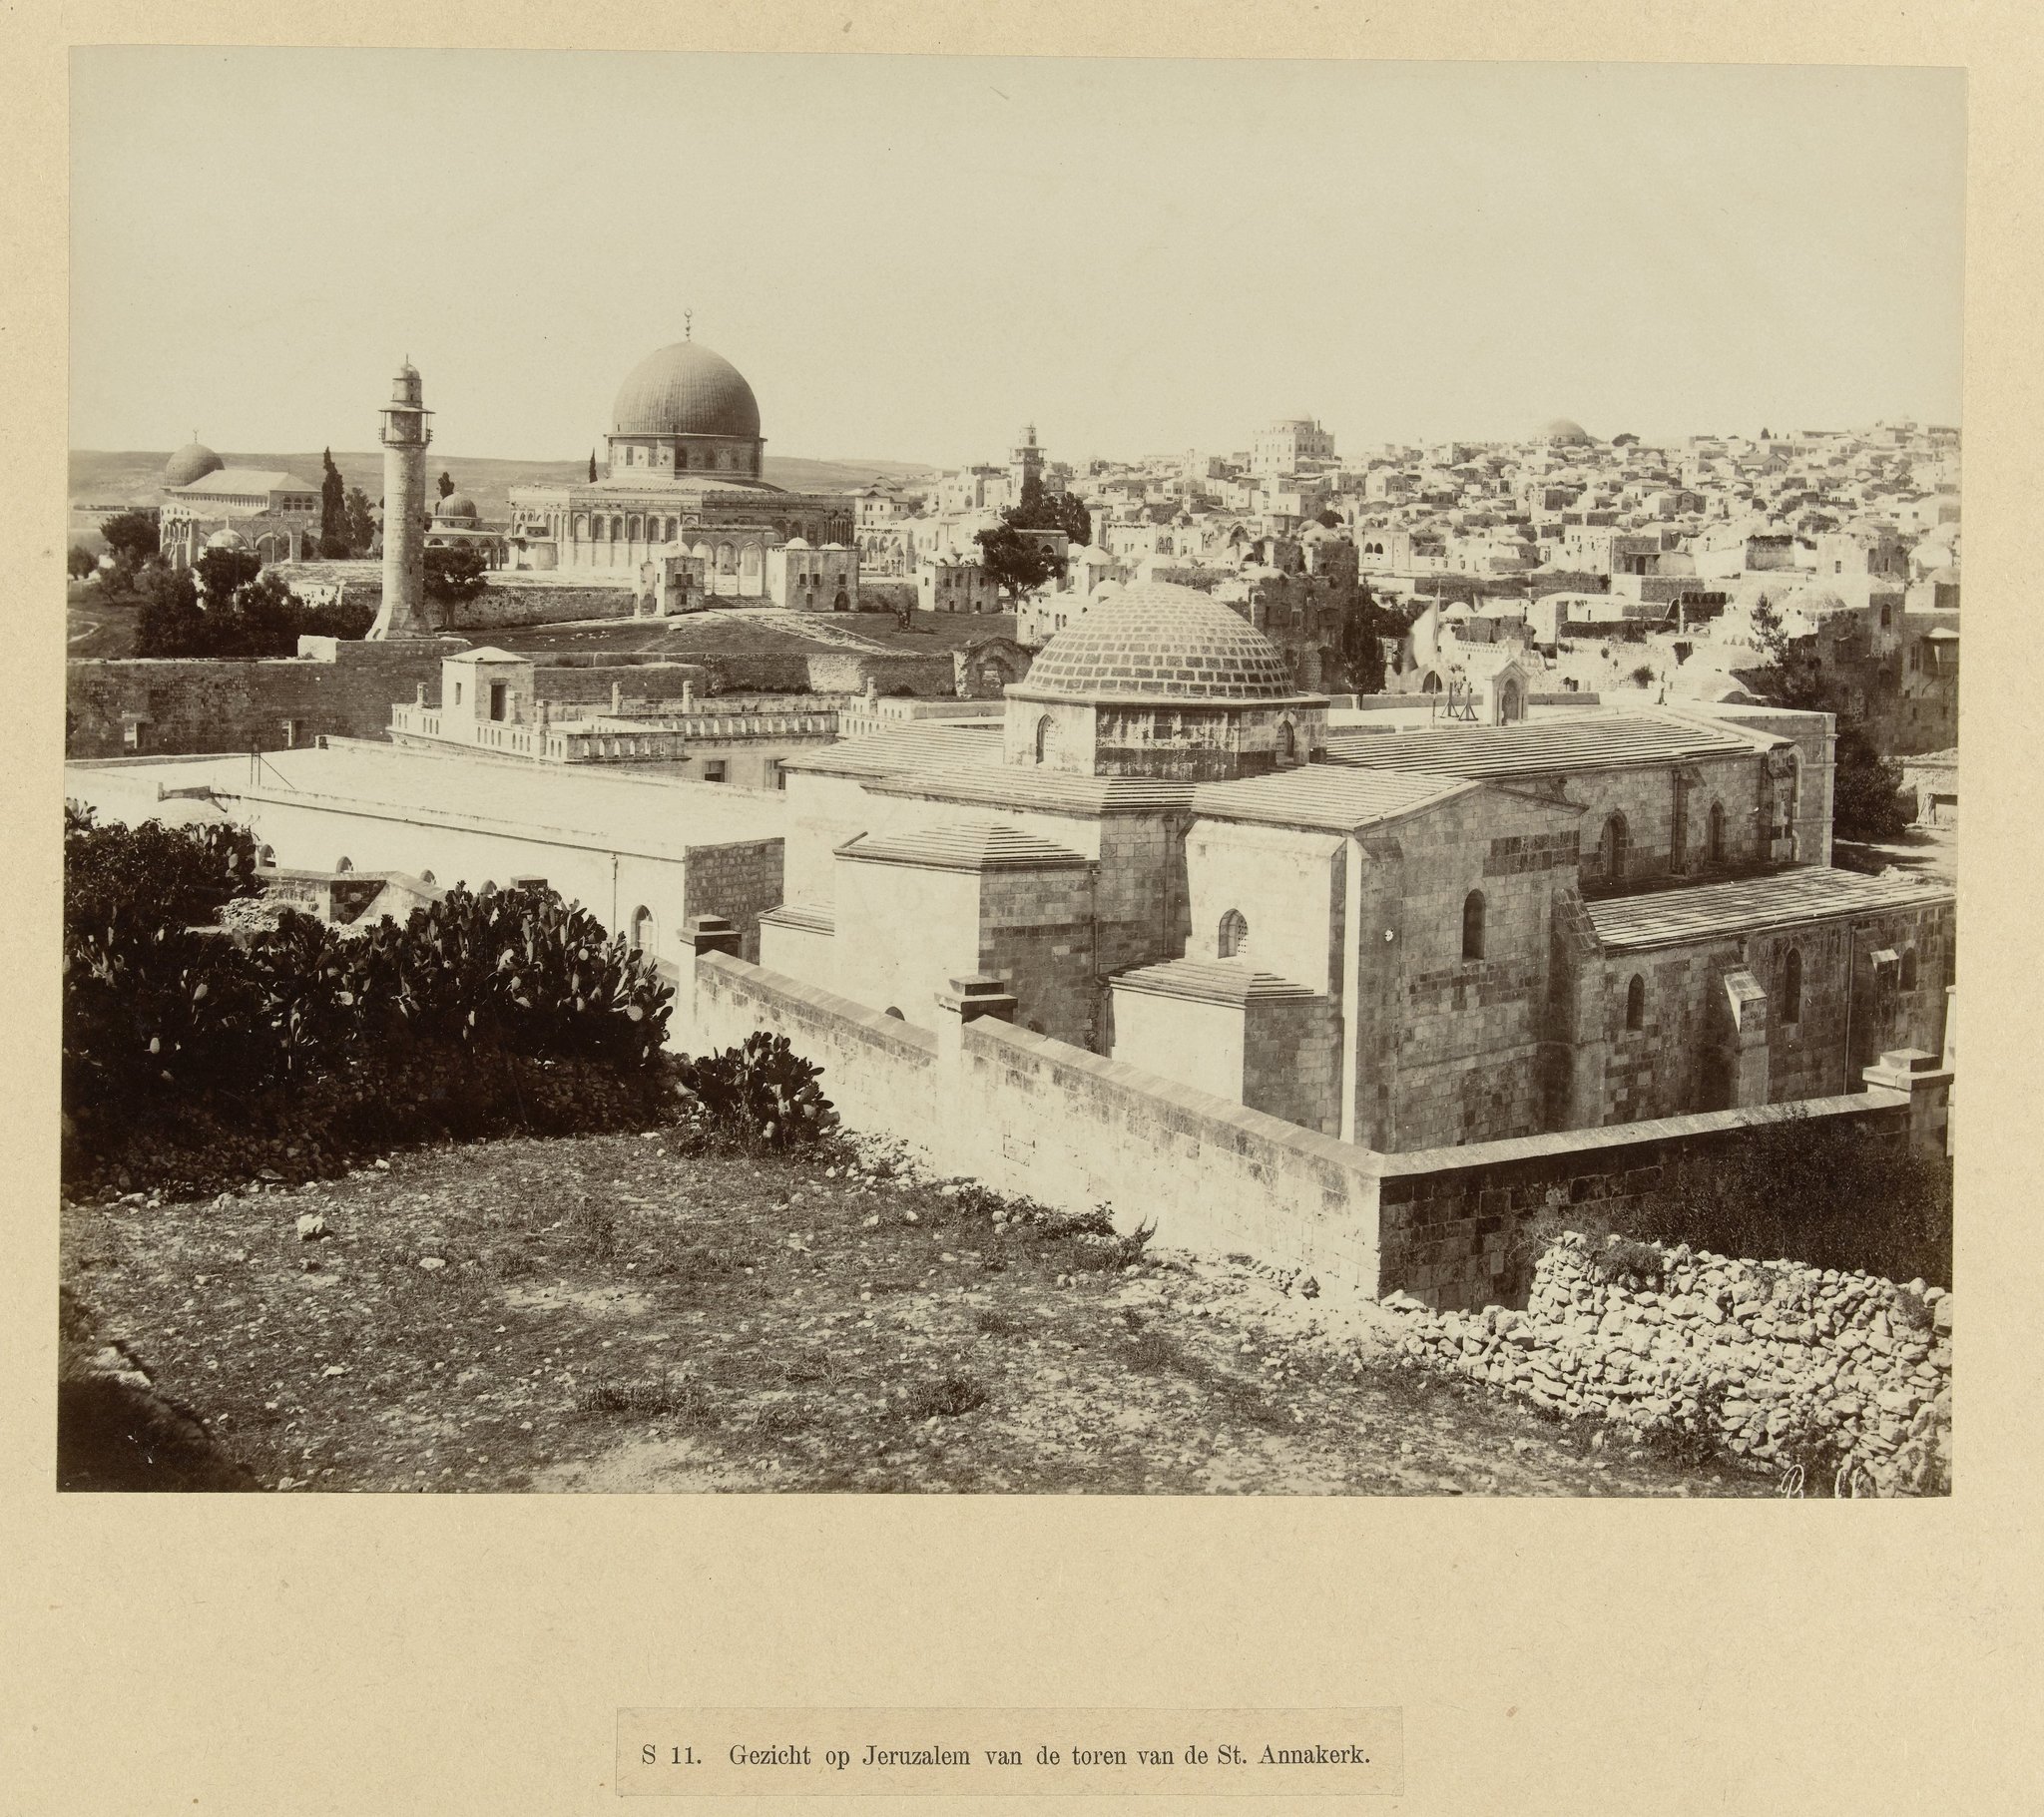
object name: photograph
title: S 11. Gezicht op Jeruzalem van de toren van de St. Annakerk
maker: félix bonfils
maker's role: fotograaf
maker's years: 1831-1885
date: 1867-1877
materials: cardboard, paper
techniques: albumen print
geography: jerusalem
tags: city-view in general; 'veduta', temple, shrine ~ islam, mohammedanism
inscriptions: stamp: ‘Gemeentelijke bibliotheek/ Rotterdam’, title: ‘S 11. Gezicht op Jeruzalem van de toren van de St. Annakerk.’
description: Onderdeel van een groep door fotograaf Richard Polak op reis verzamelde foto’s. Deze foto is samen met andere op zijn reizen verzamelde foto's tentoongesteld bij de Rotterdamsche Kunstkring (1895), Arti en Amicitiae te Amsterdam (1897-1898?) en Societeit 't Collegie te Kampen (datum vooralsnog onbekend).